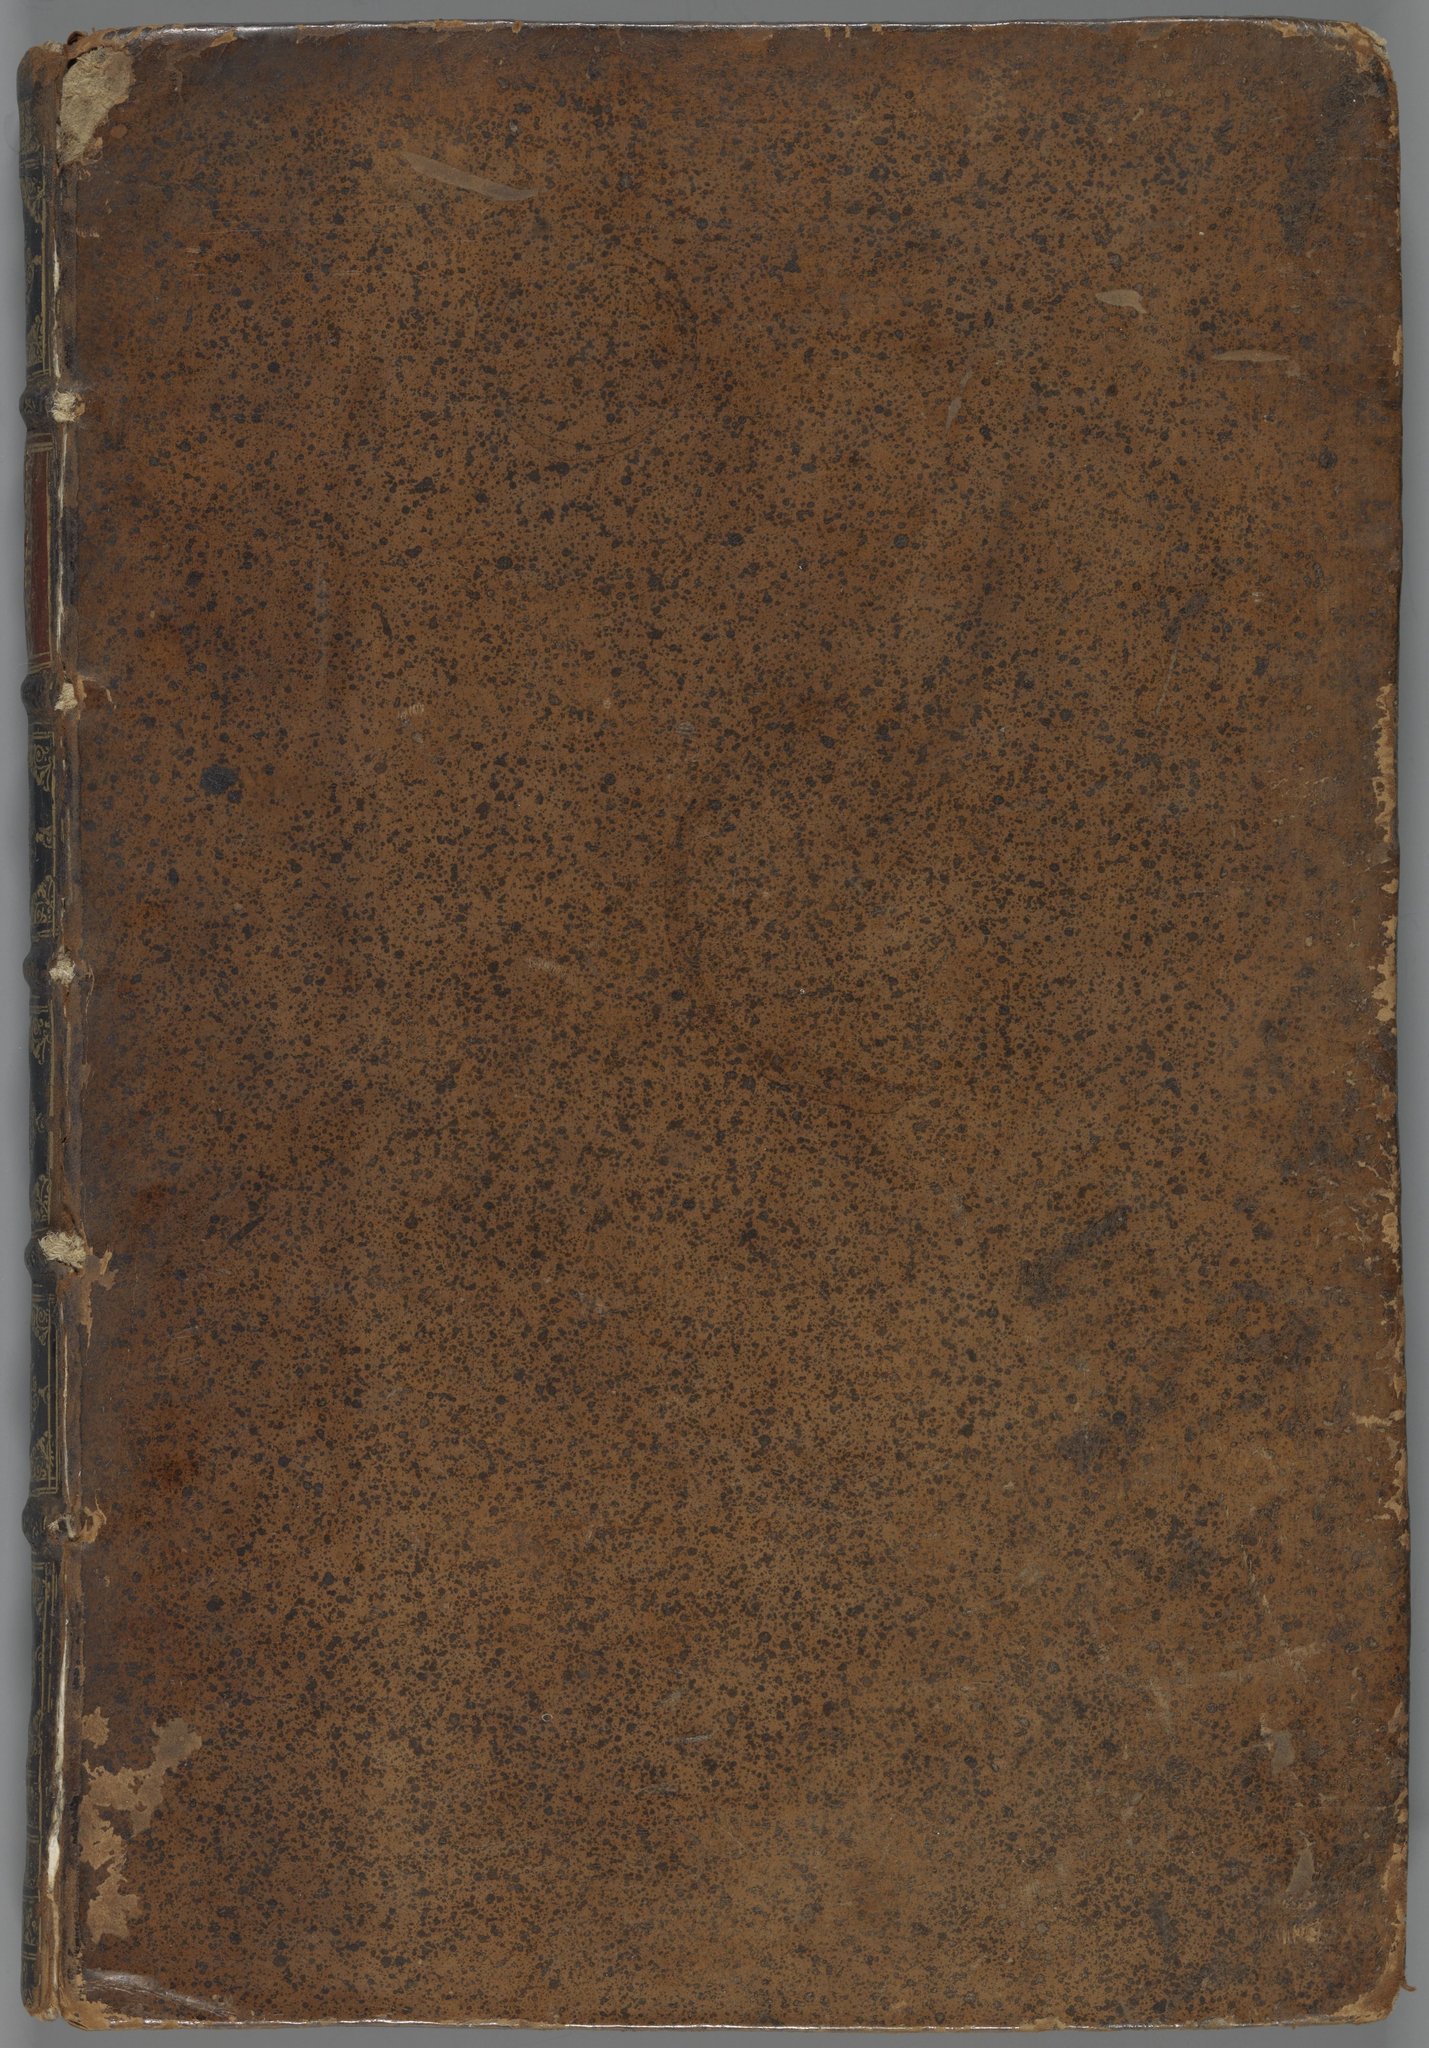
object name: prentrecueil, prentenalbum, prentalbum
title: Effigies Cardinalum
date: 1658-1691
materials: leather, paper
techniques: bookbinding, engraving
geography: rome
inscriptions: inscription: ‘A / sh 4 - B 14’, inscription: ‘B / sh B / 4 17’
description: De oorspronkelijke serie kardinalen met het portret van paus Alexander VII werd uitgegeven in 1658. Dit album bevat ook kardinalen uit latere jaren en het portret van paus Clemens X (1670-1676). Enkele portretten zijn in of na 1675 gegraveerd. De datering van dit album is gebaseerd op de titelprent, de uitgave van de prenten in het album en de werkzame periode van de uitgever.